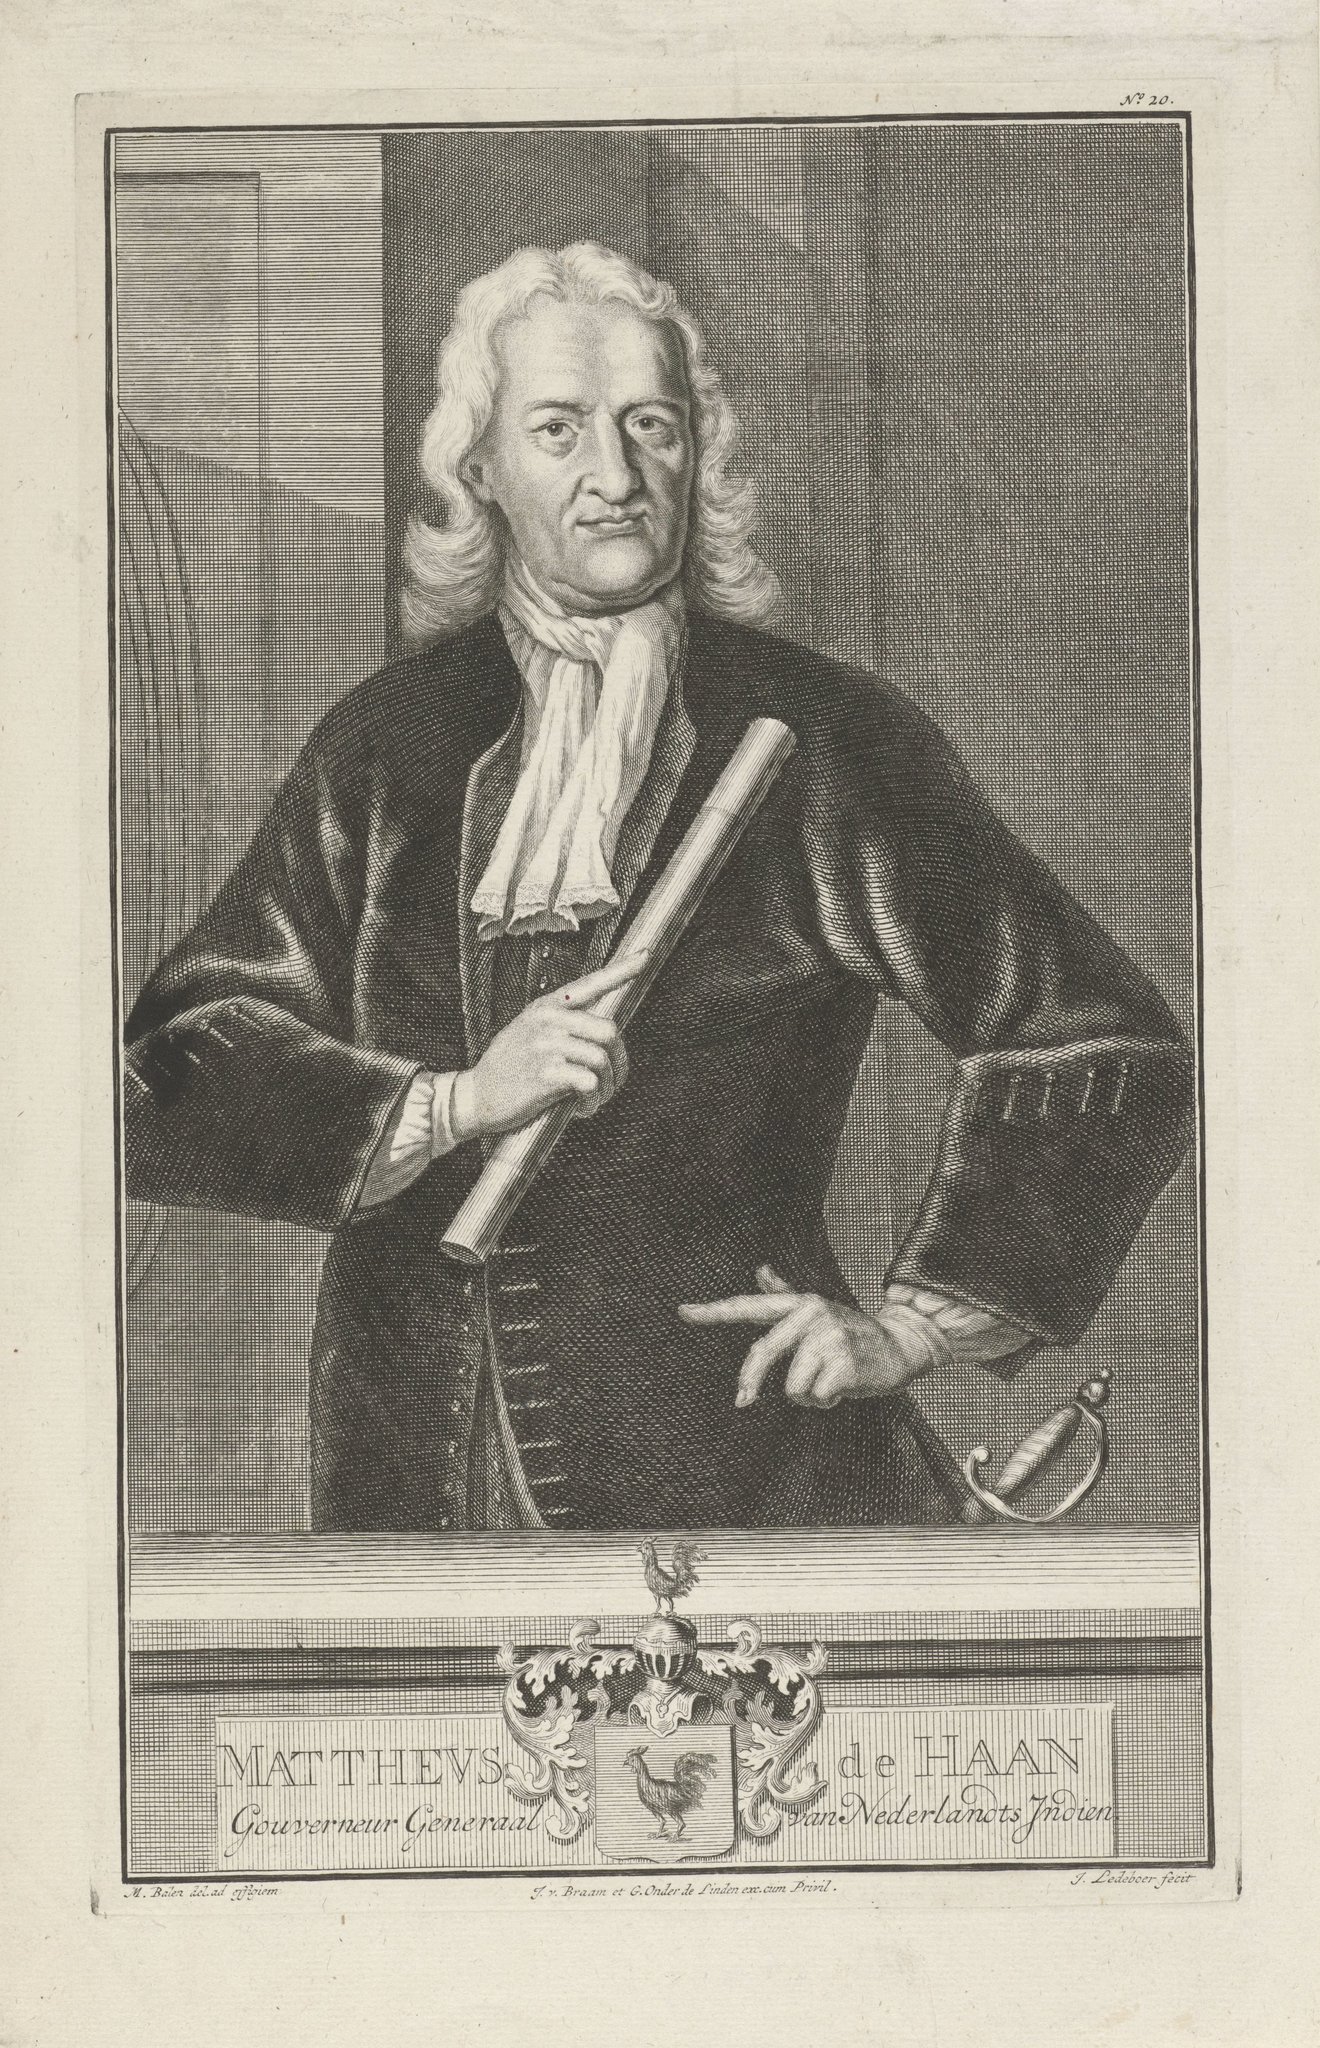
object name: print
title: Portret van Mattheus de Haan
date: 1702-1749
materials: paper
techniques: engraving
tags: dordrecht, batavia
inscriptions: collector's mark: Lugt 2228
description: Portret ten halven lijve van voren van Mattheus de Haan, gouverneur-generaal van Nederlands-Indië, blootshoofds en met commandostaf in de hand. Onder het portret staan de naam, titel en het wapenschild van de geportretteerde. Prent rechtsboven gemerkt: No. 20.